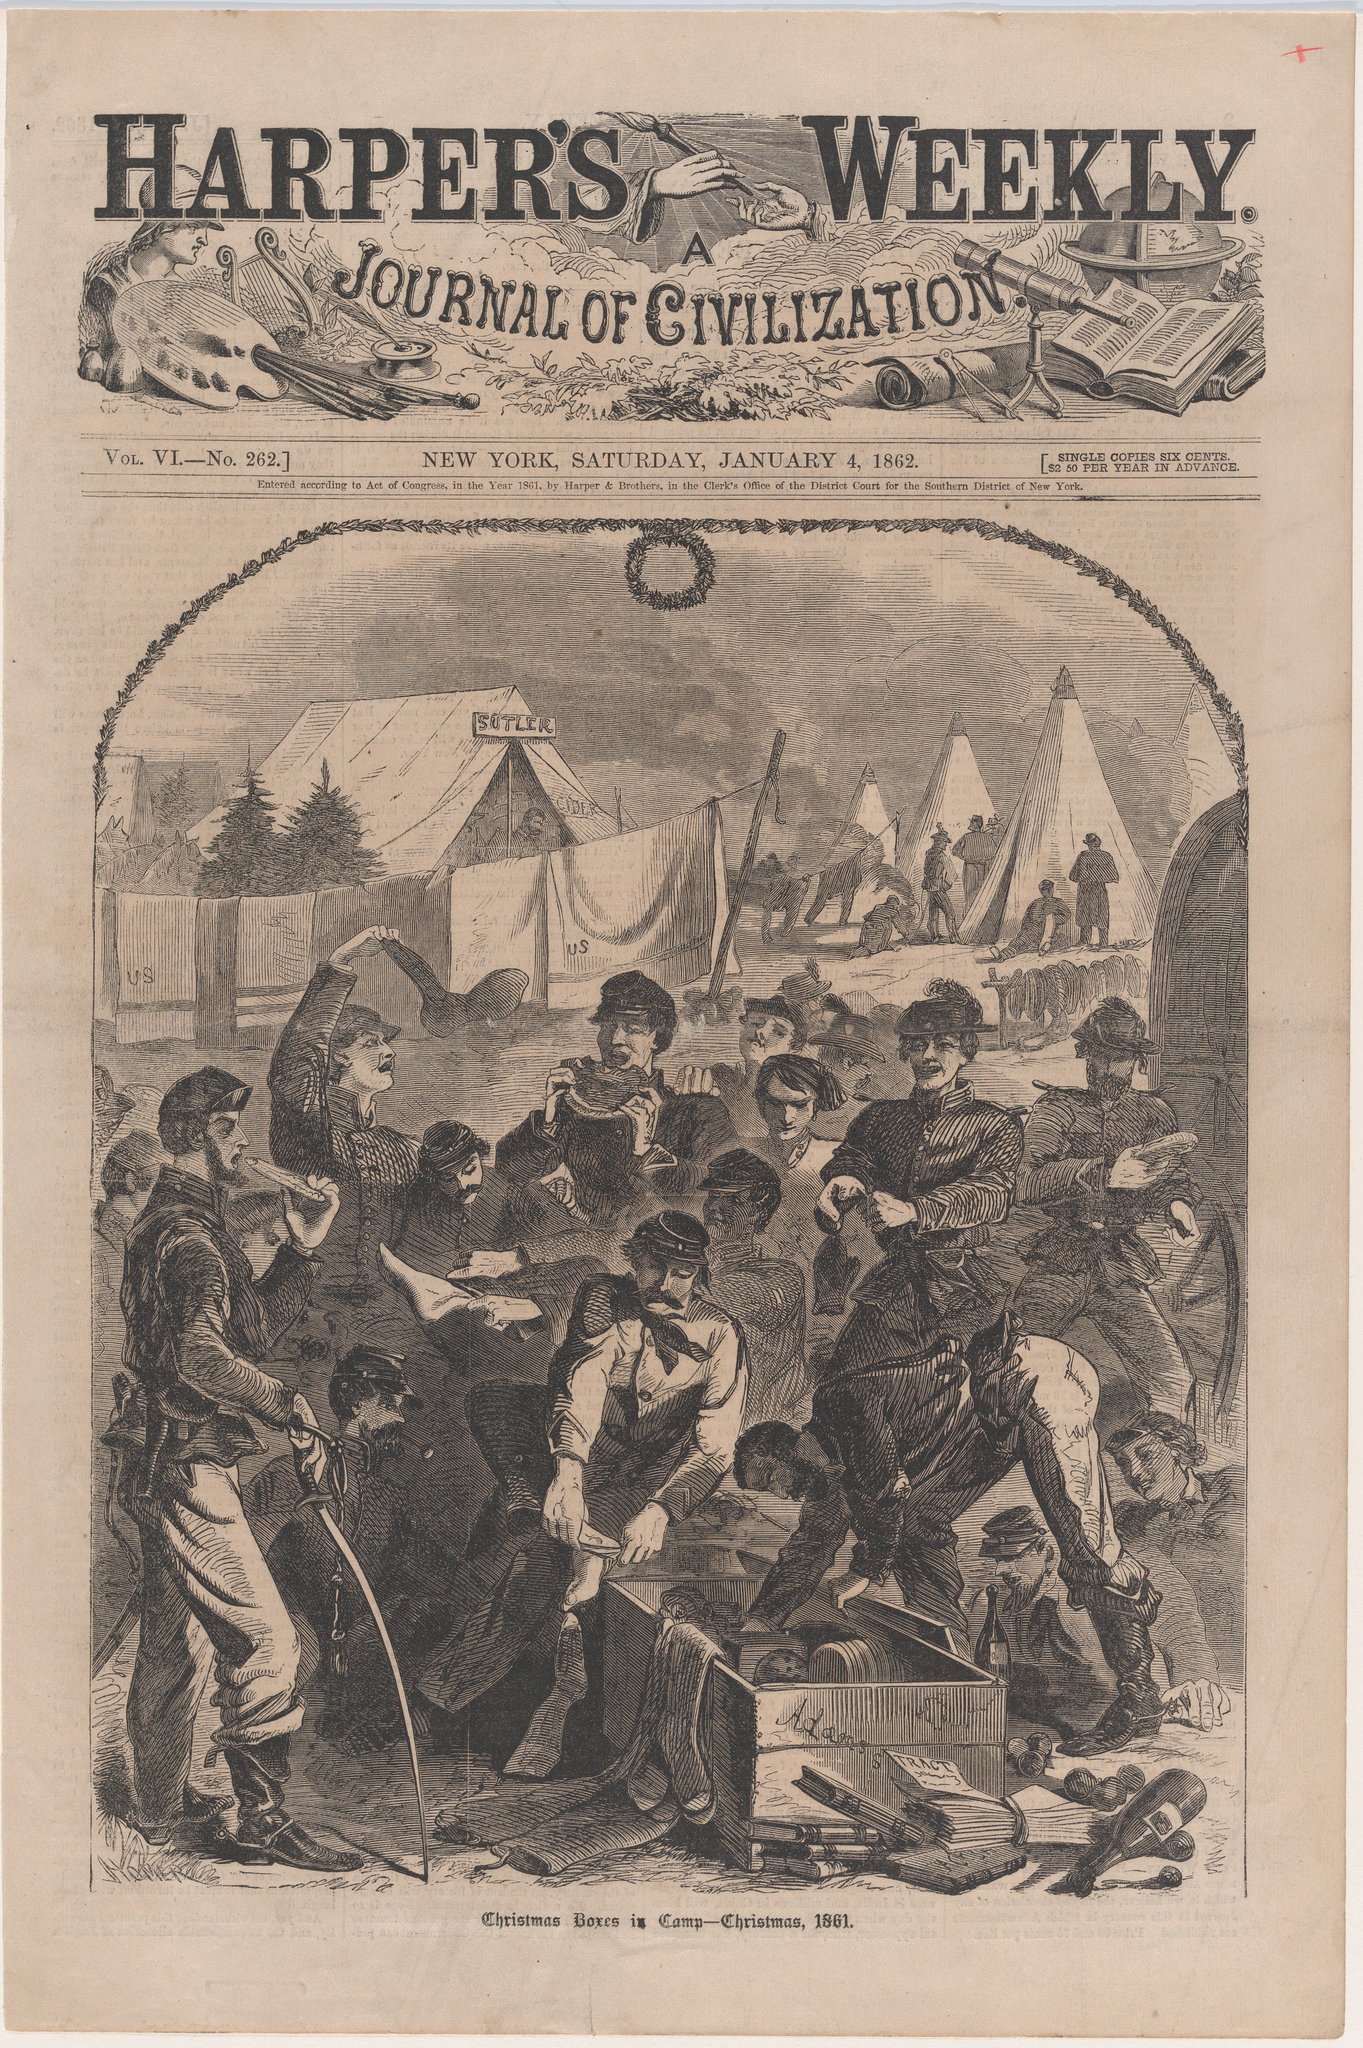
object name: print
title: Christmas Boxes in Camp – Christmas, 1861 (from "Harper's Weekly," Vol. VI)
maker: winslow homer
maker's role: artist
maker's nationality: american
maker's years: 1836-1910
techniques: engraving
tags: tents,soldiers,american civil war,men,christmas